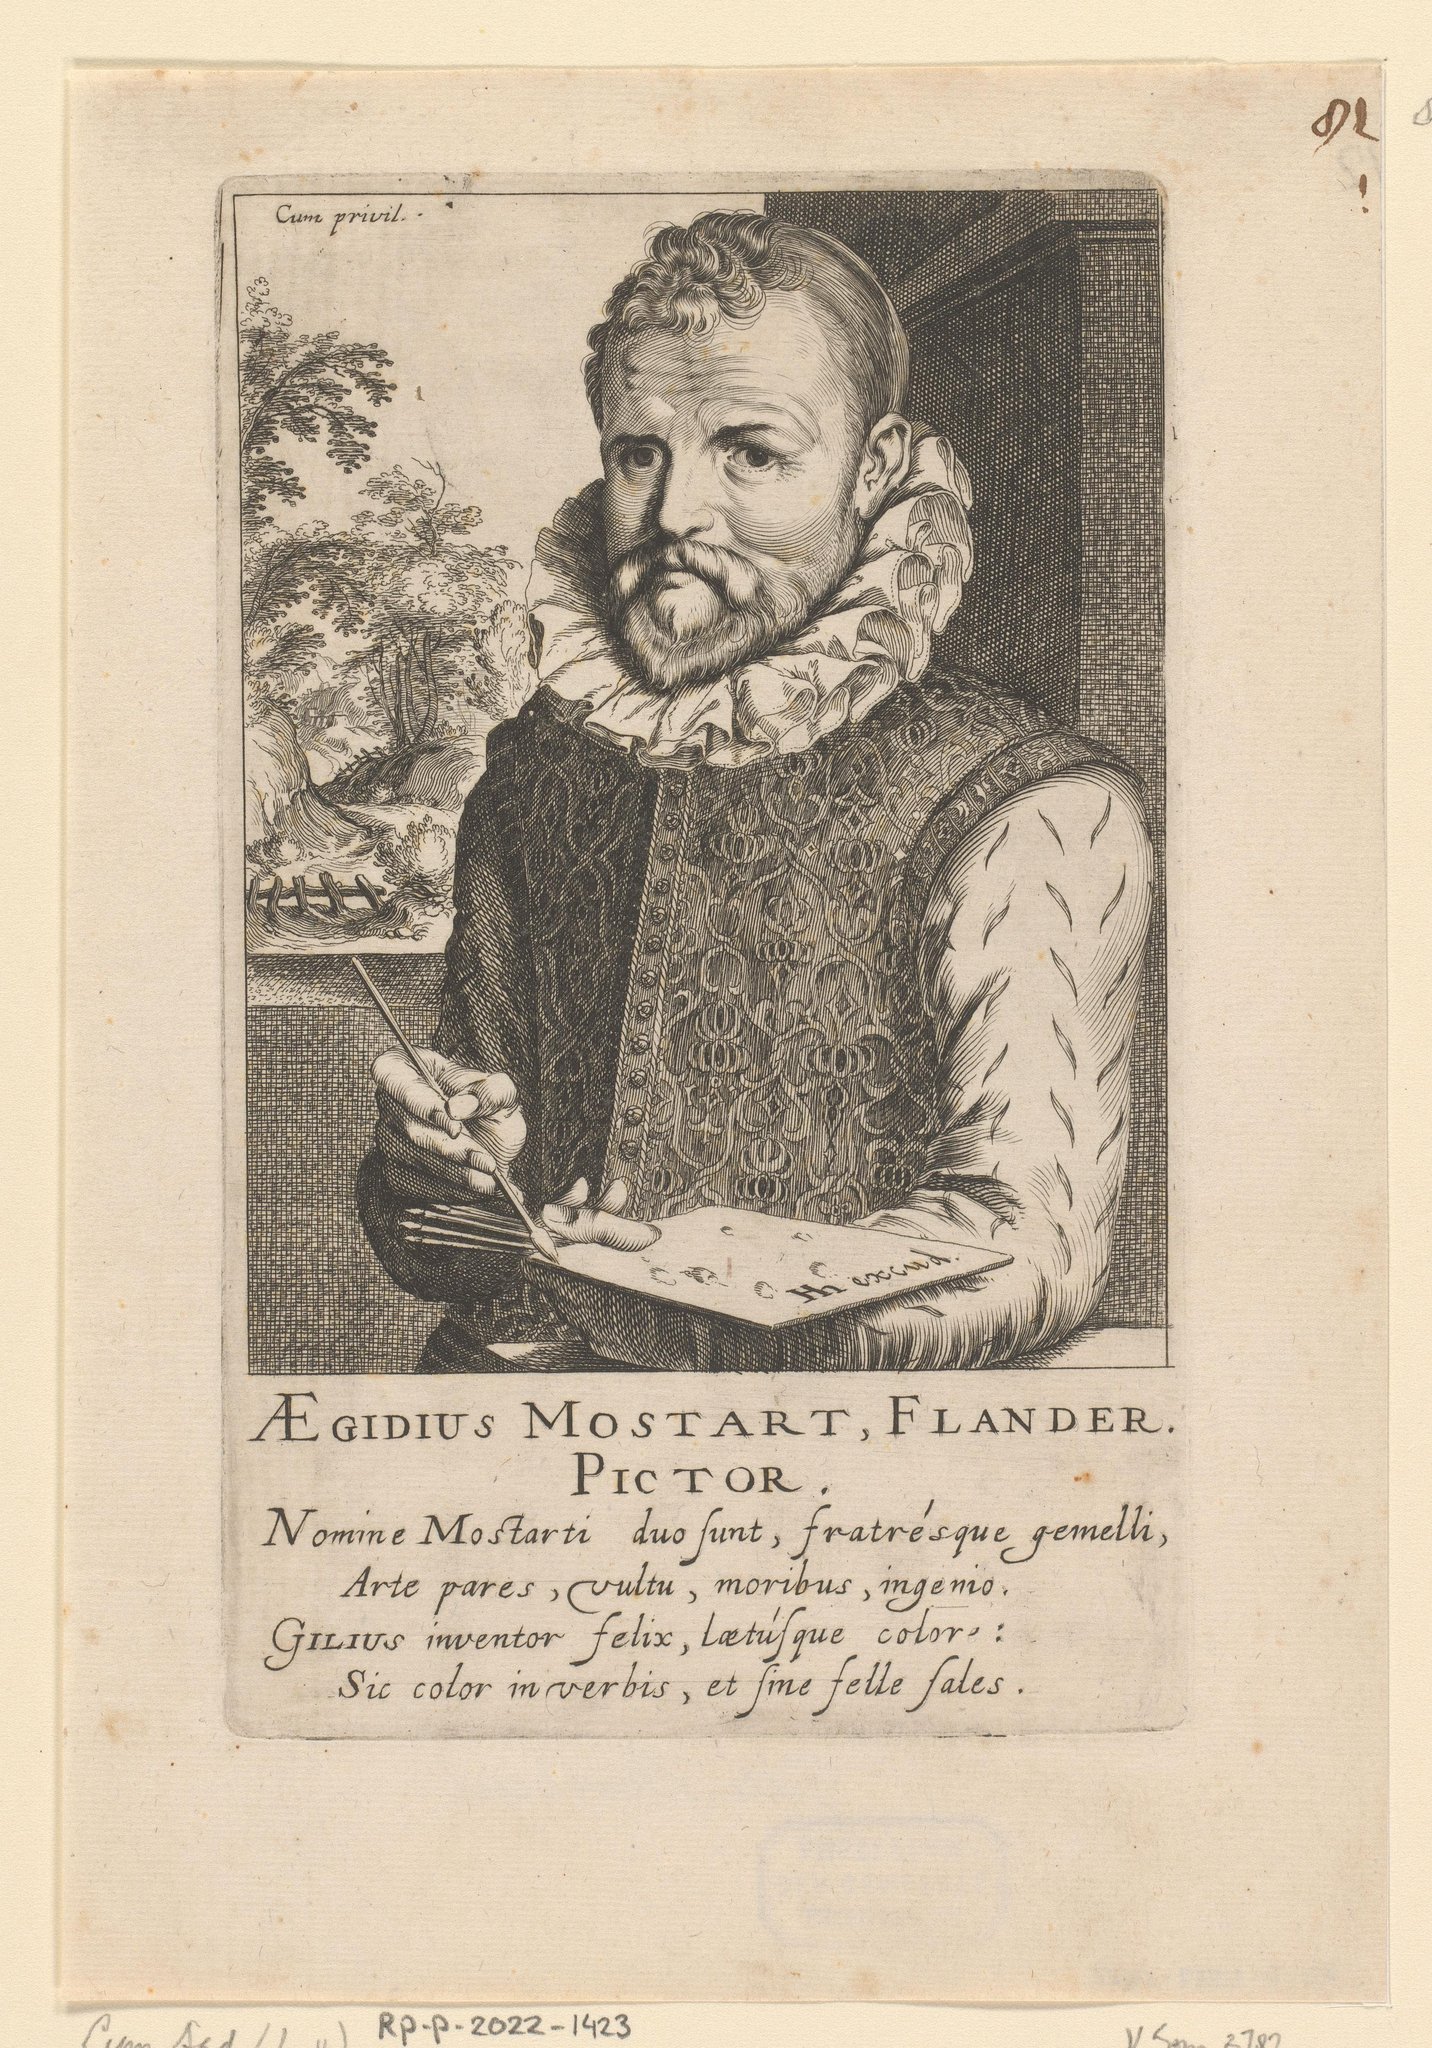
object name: print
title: Portret van Gilles Mostaert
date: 1610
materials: paper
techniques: engraving, etching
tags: gilles mostaert, historical persons, portrait, self-portrait of painter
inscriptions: collector's mark: Lugt 11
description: Prent waarschijnlijk uit: Hondius, Hendrick. Pictorum aliquot celebrium praecipué Germaniae inferioris Effigies. Den Haag: Hendrick Hondius, 1610, dl. 1, p. 39.